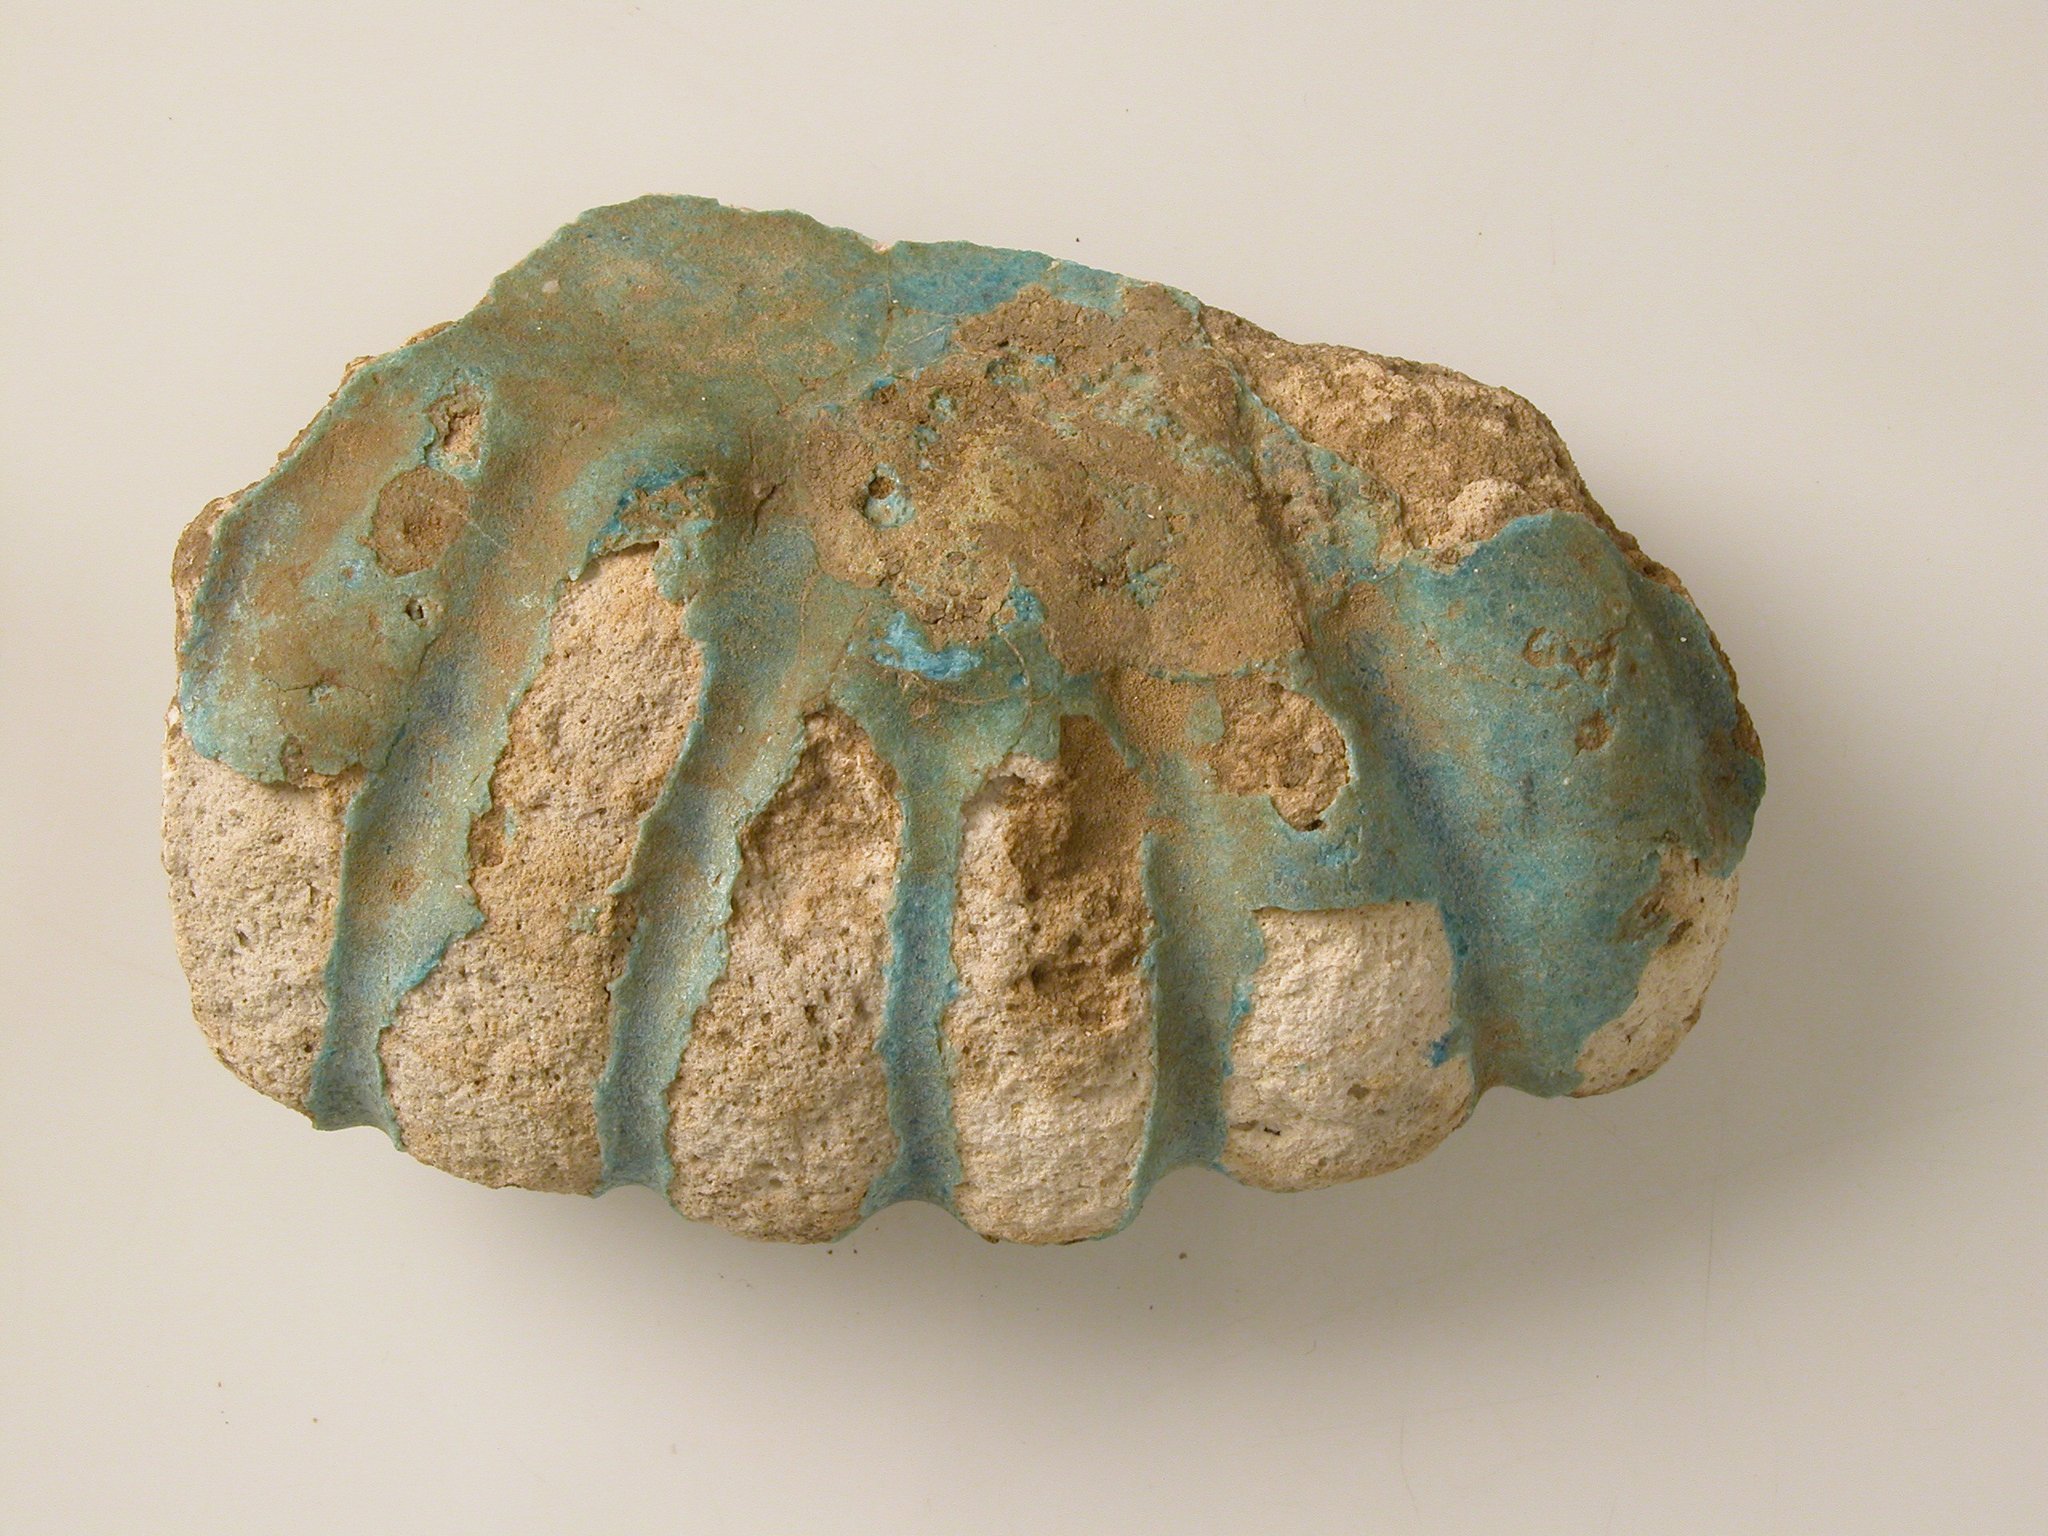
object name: fragment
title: Pottery Fragment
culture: coptic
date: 301-700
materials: earthenware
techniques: glazing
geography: egypt